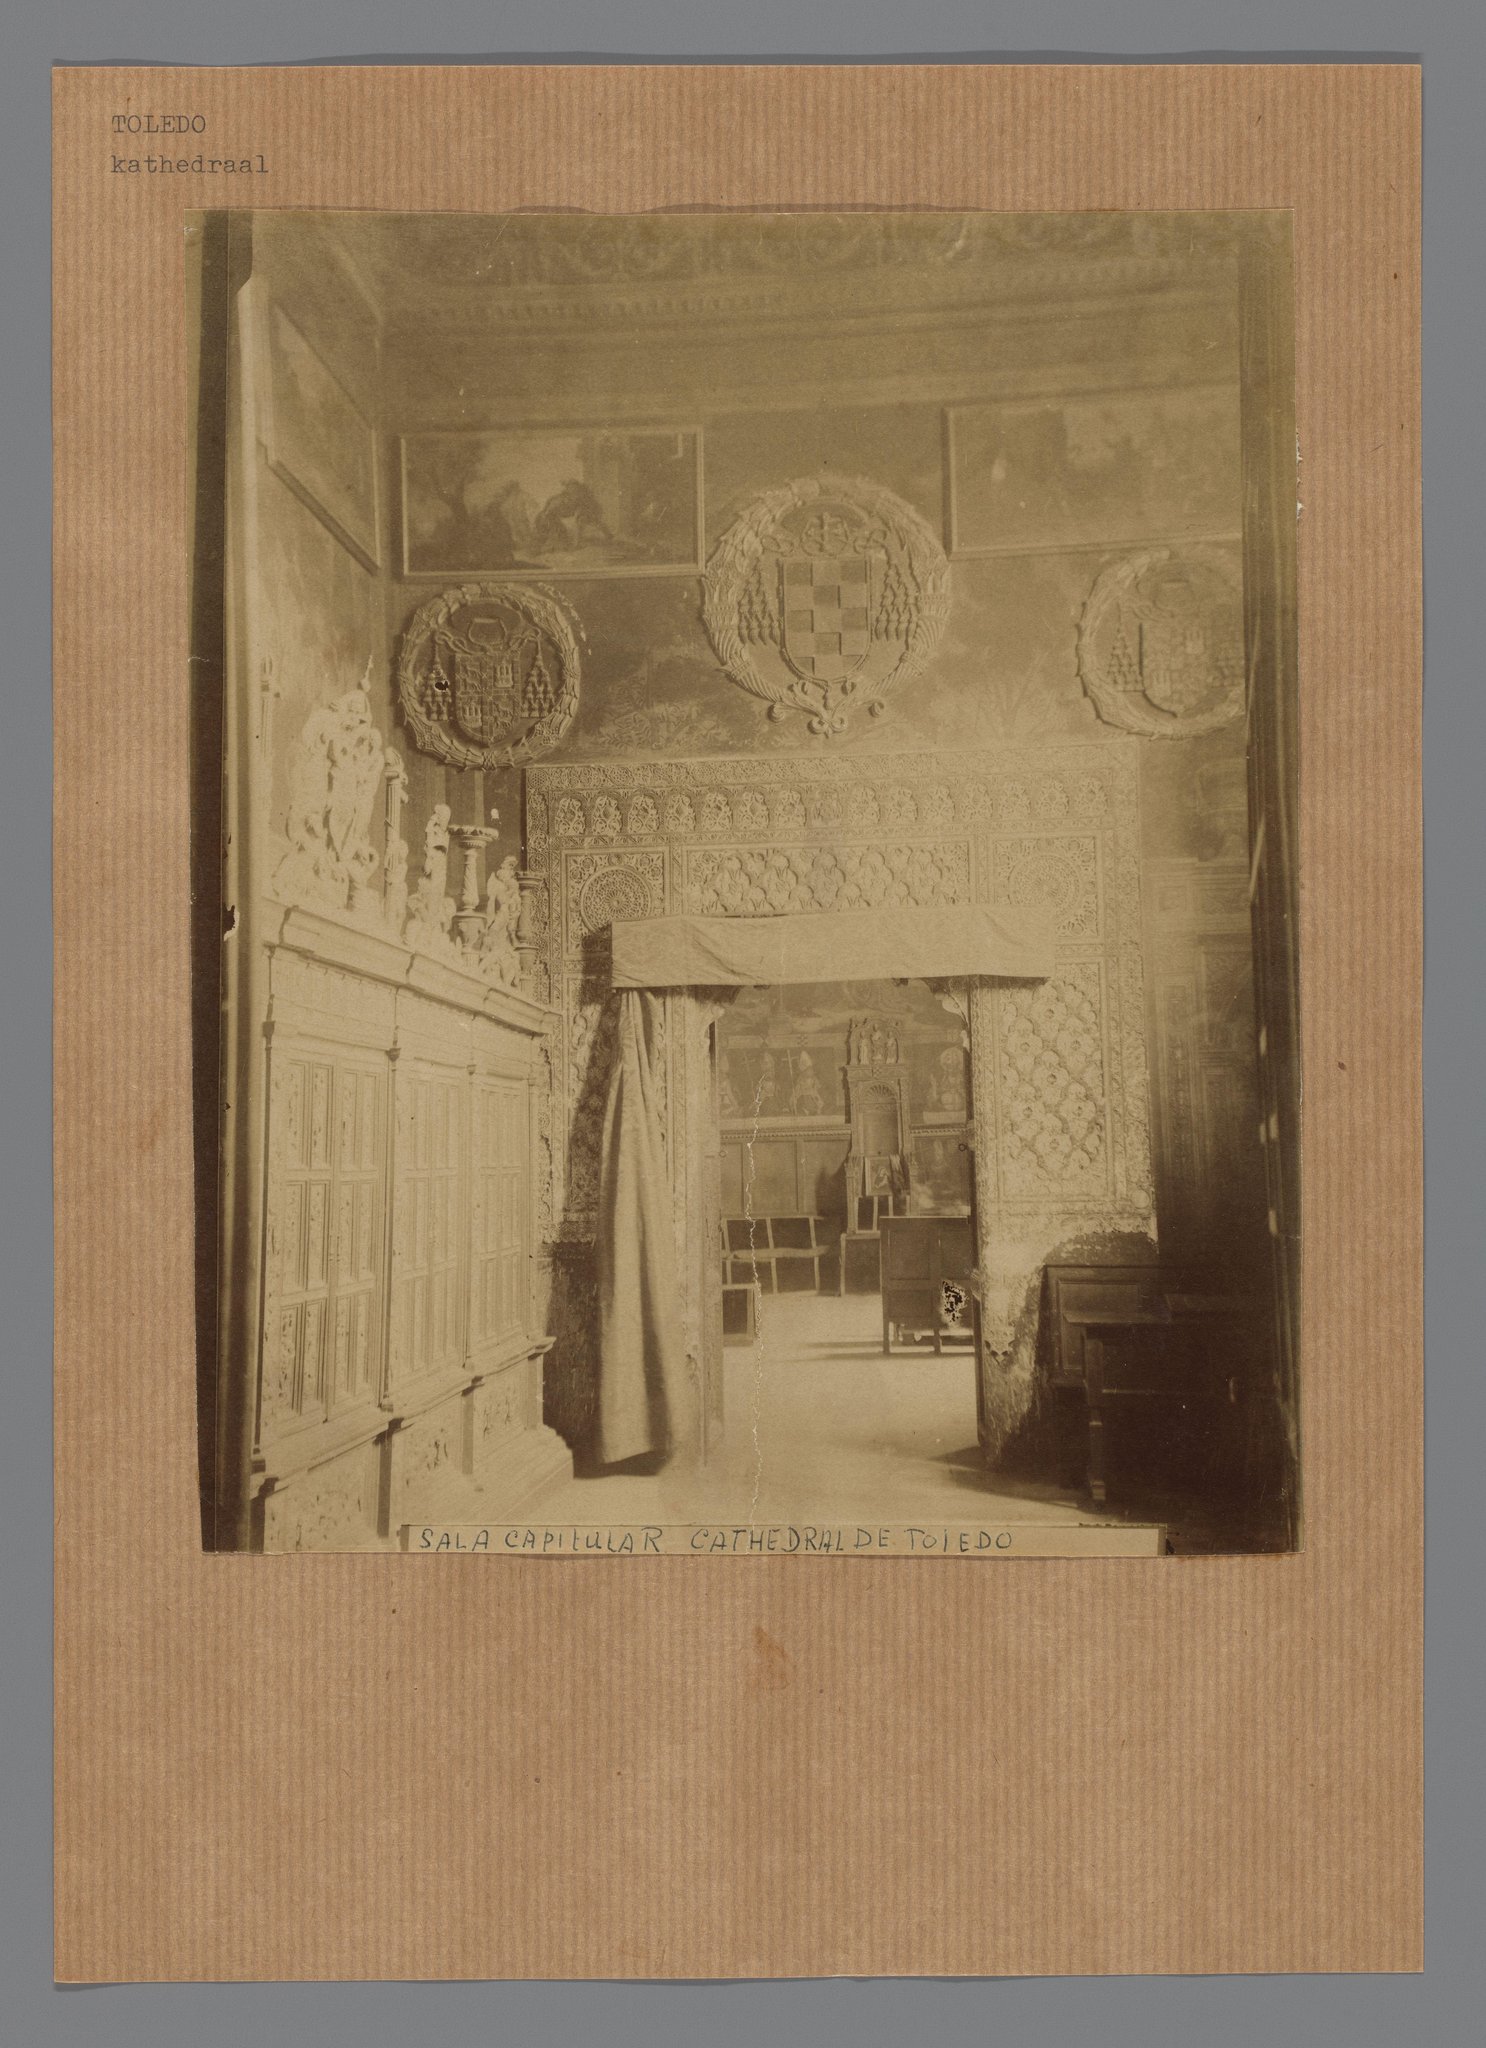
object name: photograph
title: Sala Capitular, kathedraal te Toledo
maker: Anonymous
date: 1850-1899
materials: paper, photographic support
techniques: albumen print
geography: spain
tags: toledo cathedral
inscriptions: stamp: ‘UNIVERSITEIT VAN AMSTERDAM / KUNST / HISTORISCH / INSTITUUT’, inscription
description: Foto uit de studiecollectie van het Kunsthistorisch Instituut van de Universiteit van Amsterdam.